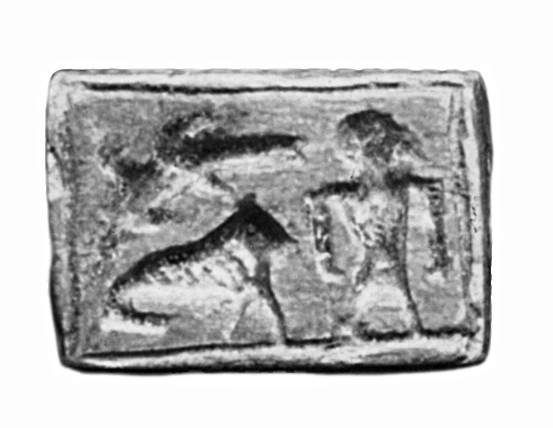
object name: plaque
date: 664-332 BCE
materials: stone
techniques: glazing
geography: egypt